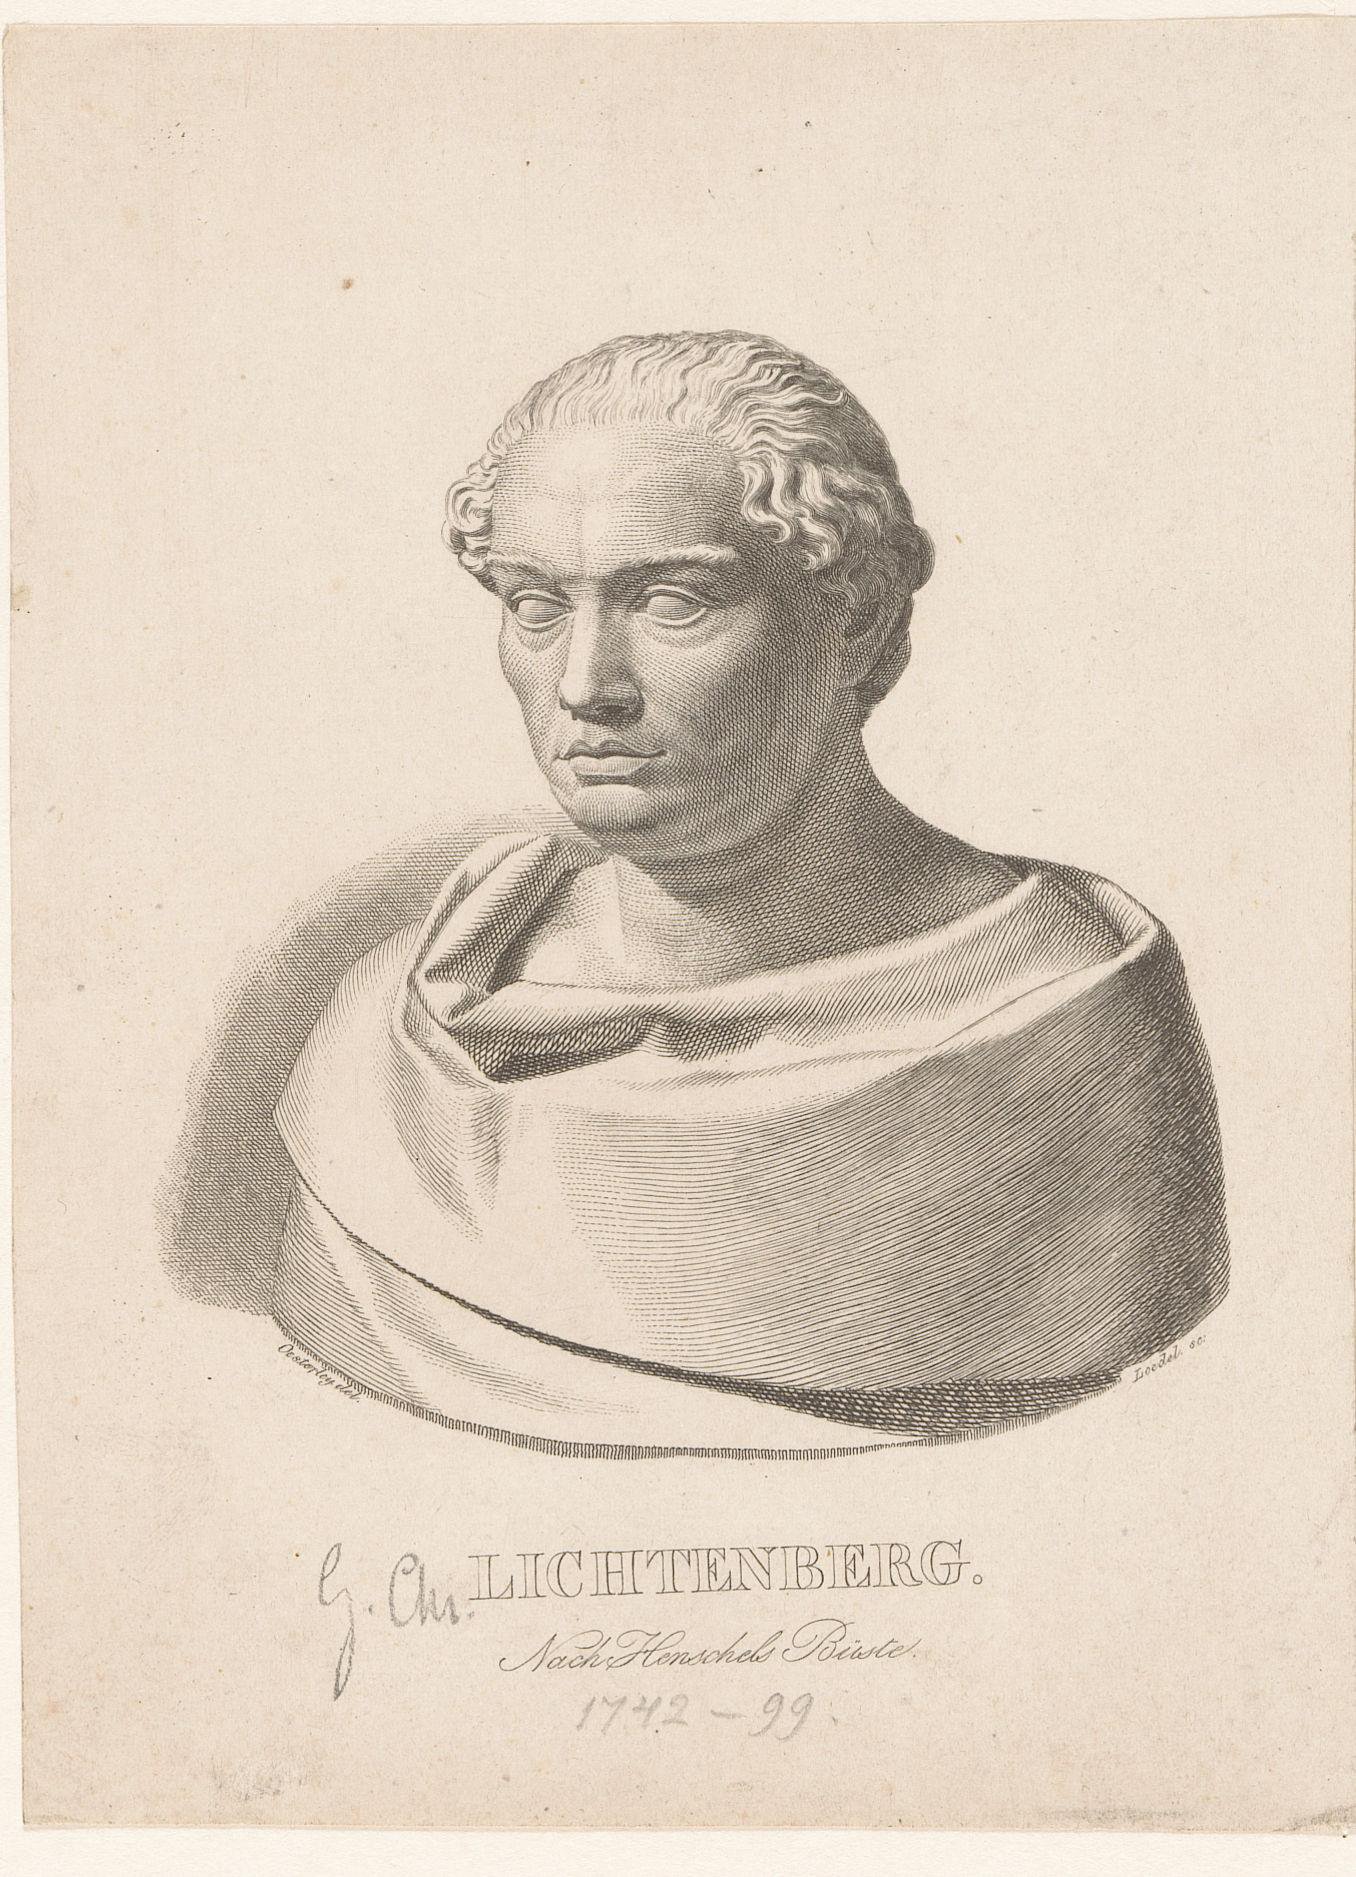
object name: print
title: Portret van Georg Christoph Lichtenberg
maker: heinrich lödel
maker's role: print maker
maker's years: 1798-1861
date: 1808-1861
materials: paper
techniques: engraving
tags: physicist, historical persons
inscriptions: collector's mark: Lugt 2228